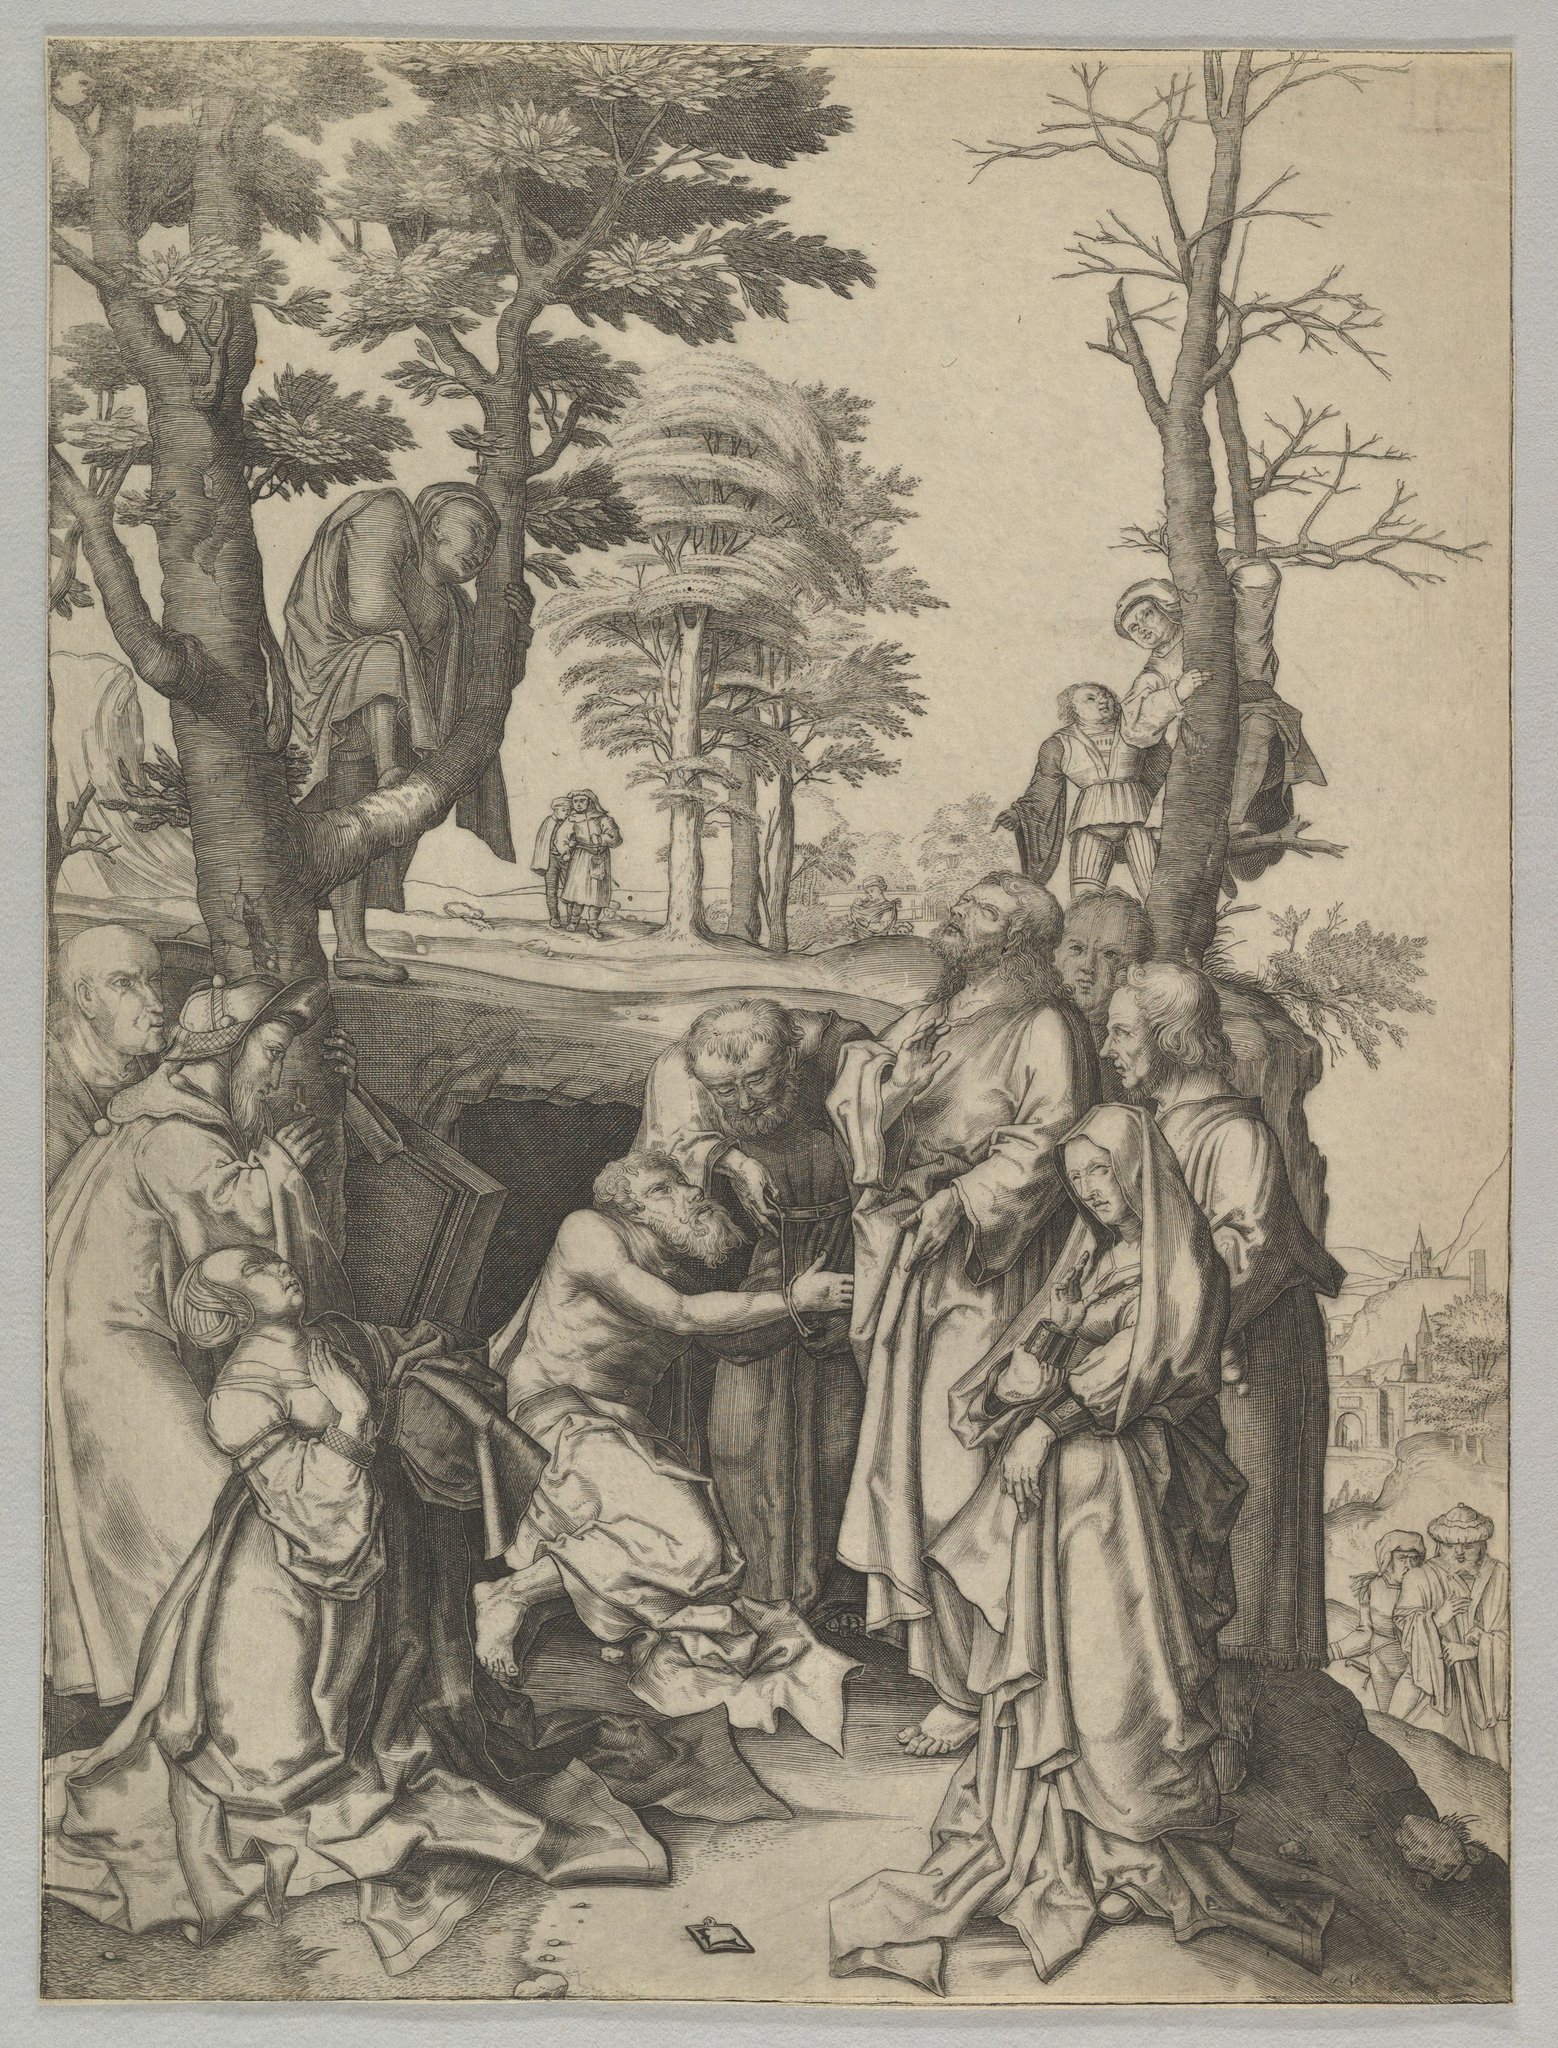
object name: print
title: The Raising of Lazarus (copy)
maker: lucas van leyden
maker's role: artist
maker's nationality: netherlandish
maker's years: 1494-1533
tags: men,women,saints